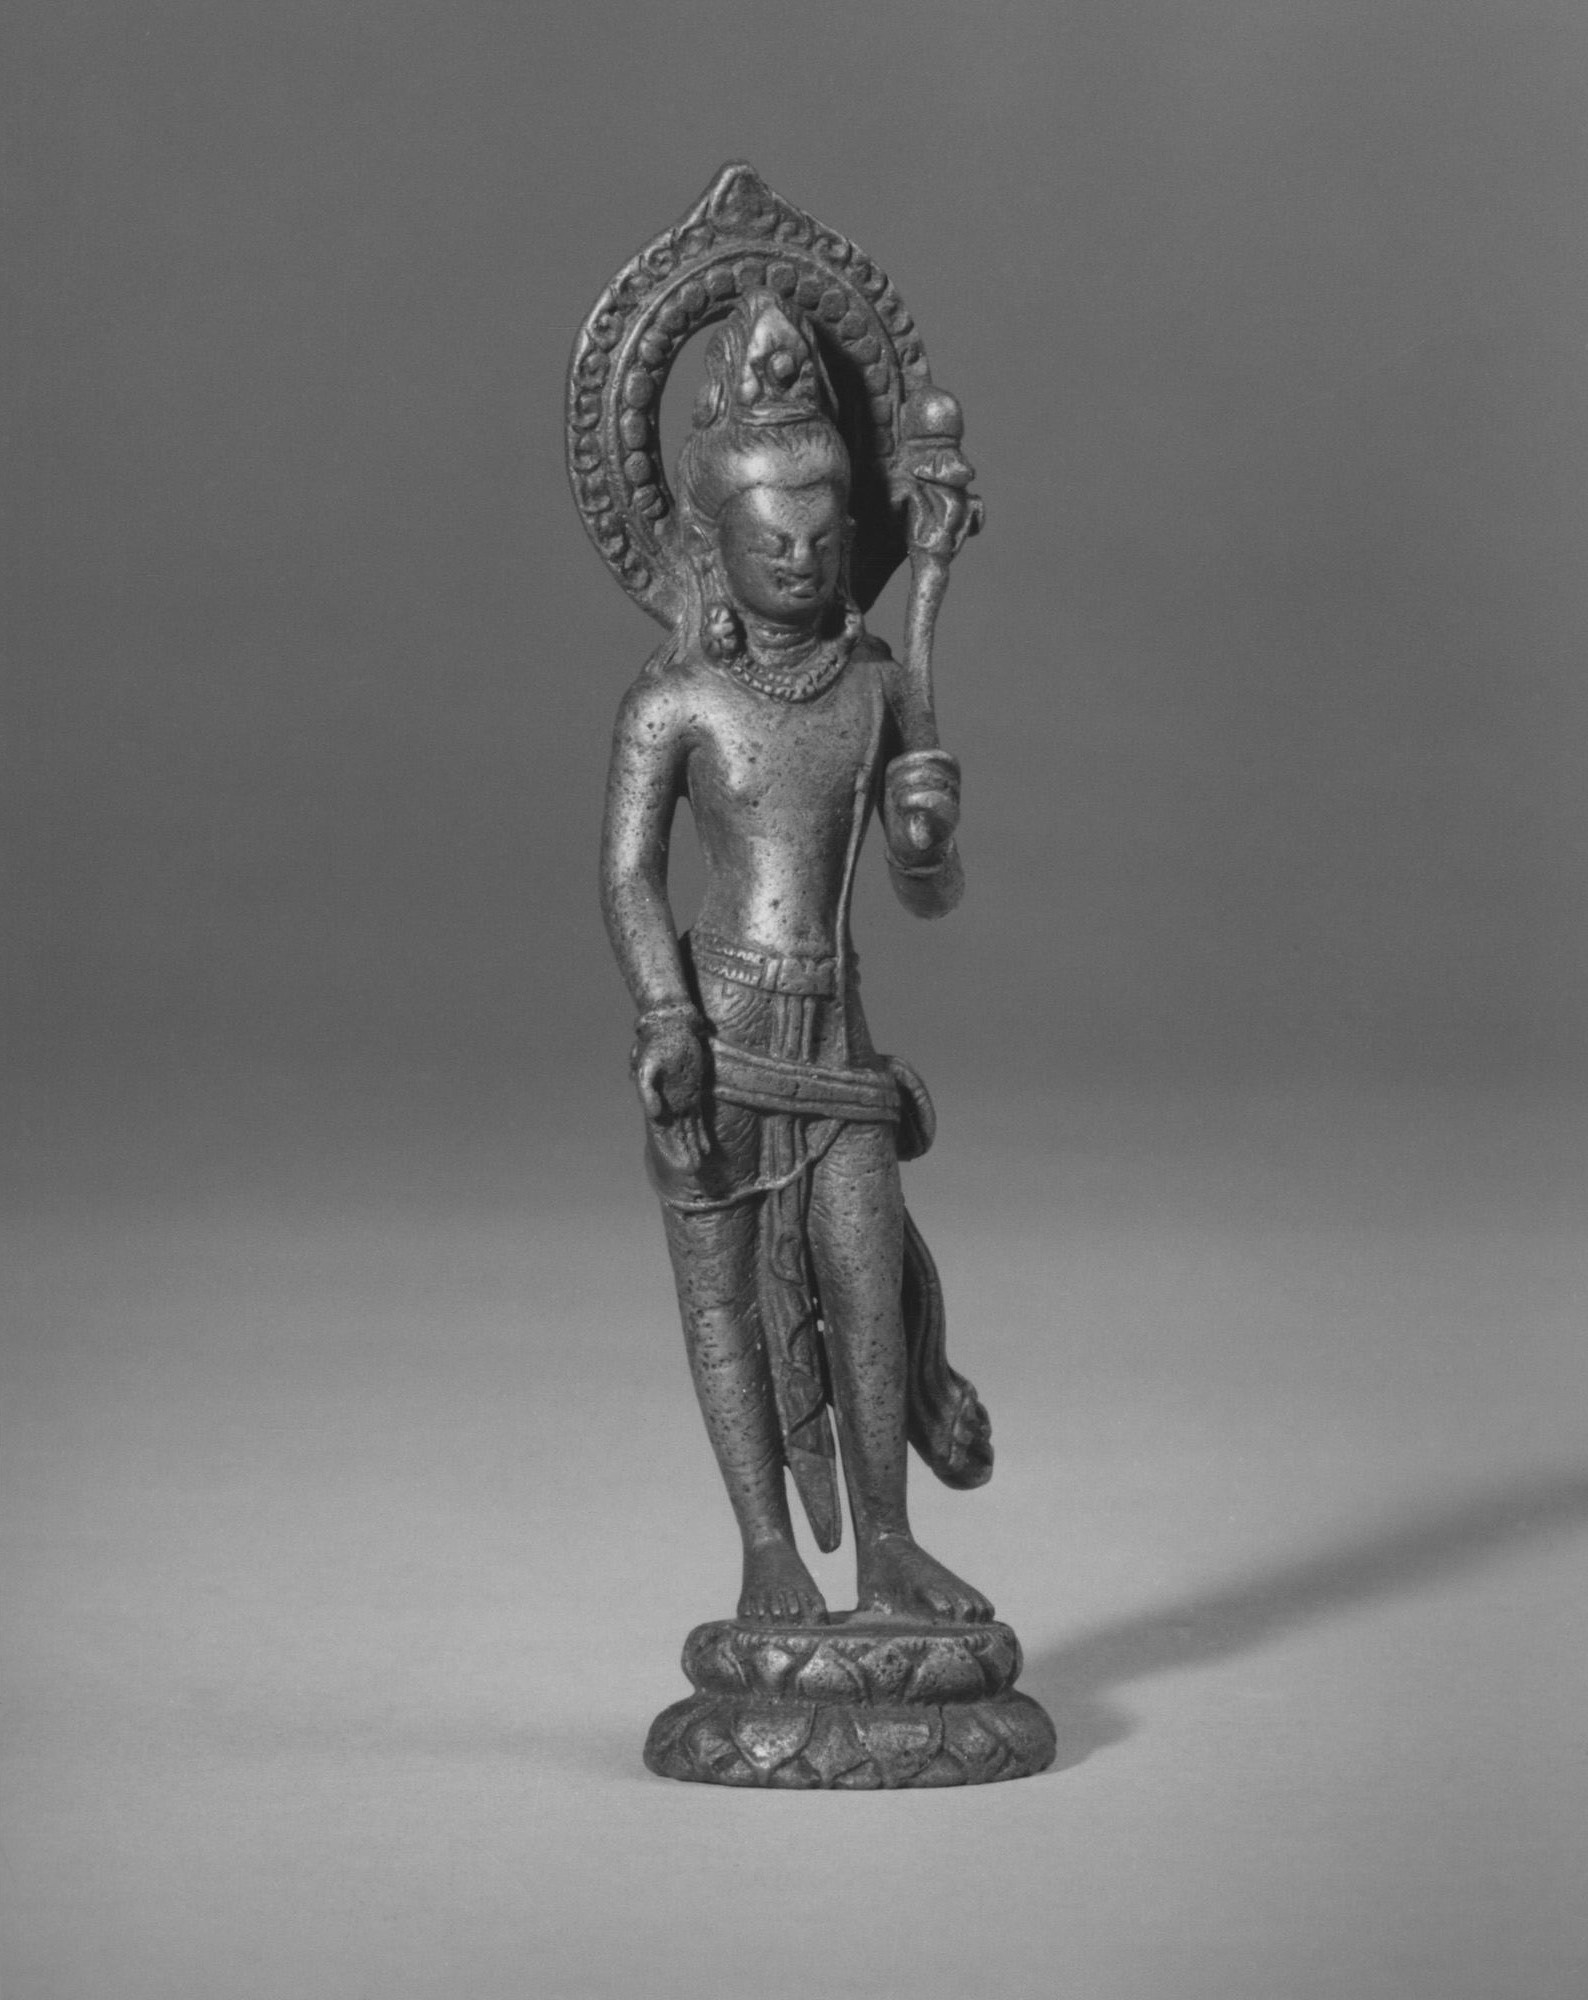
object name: figure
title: Standing Padmapani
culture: nepali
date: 701-900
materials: copper alloy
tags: buddhism,bodhisattvas